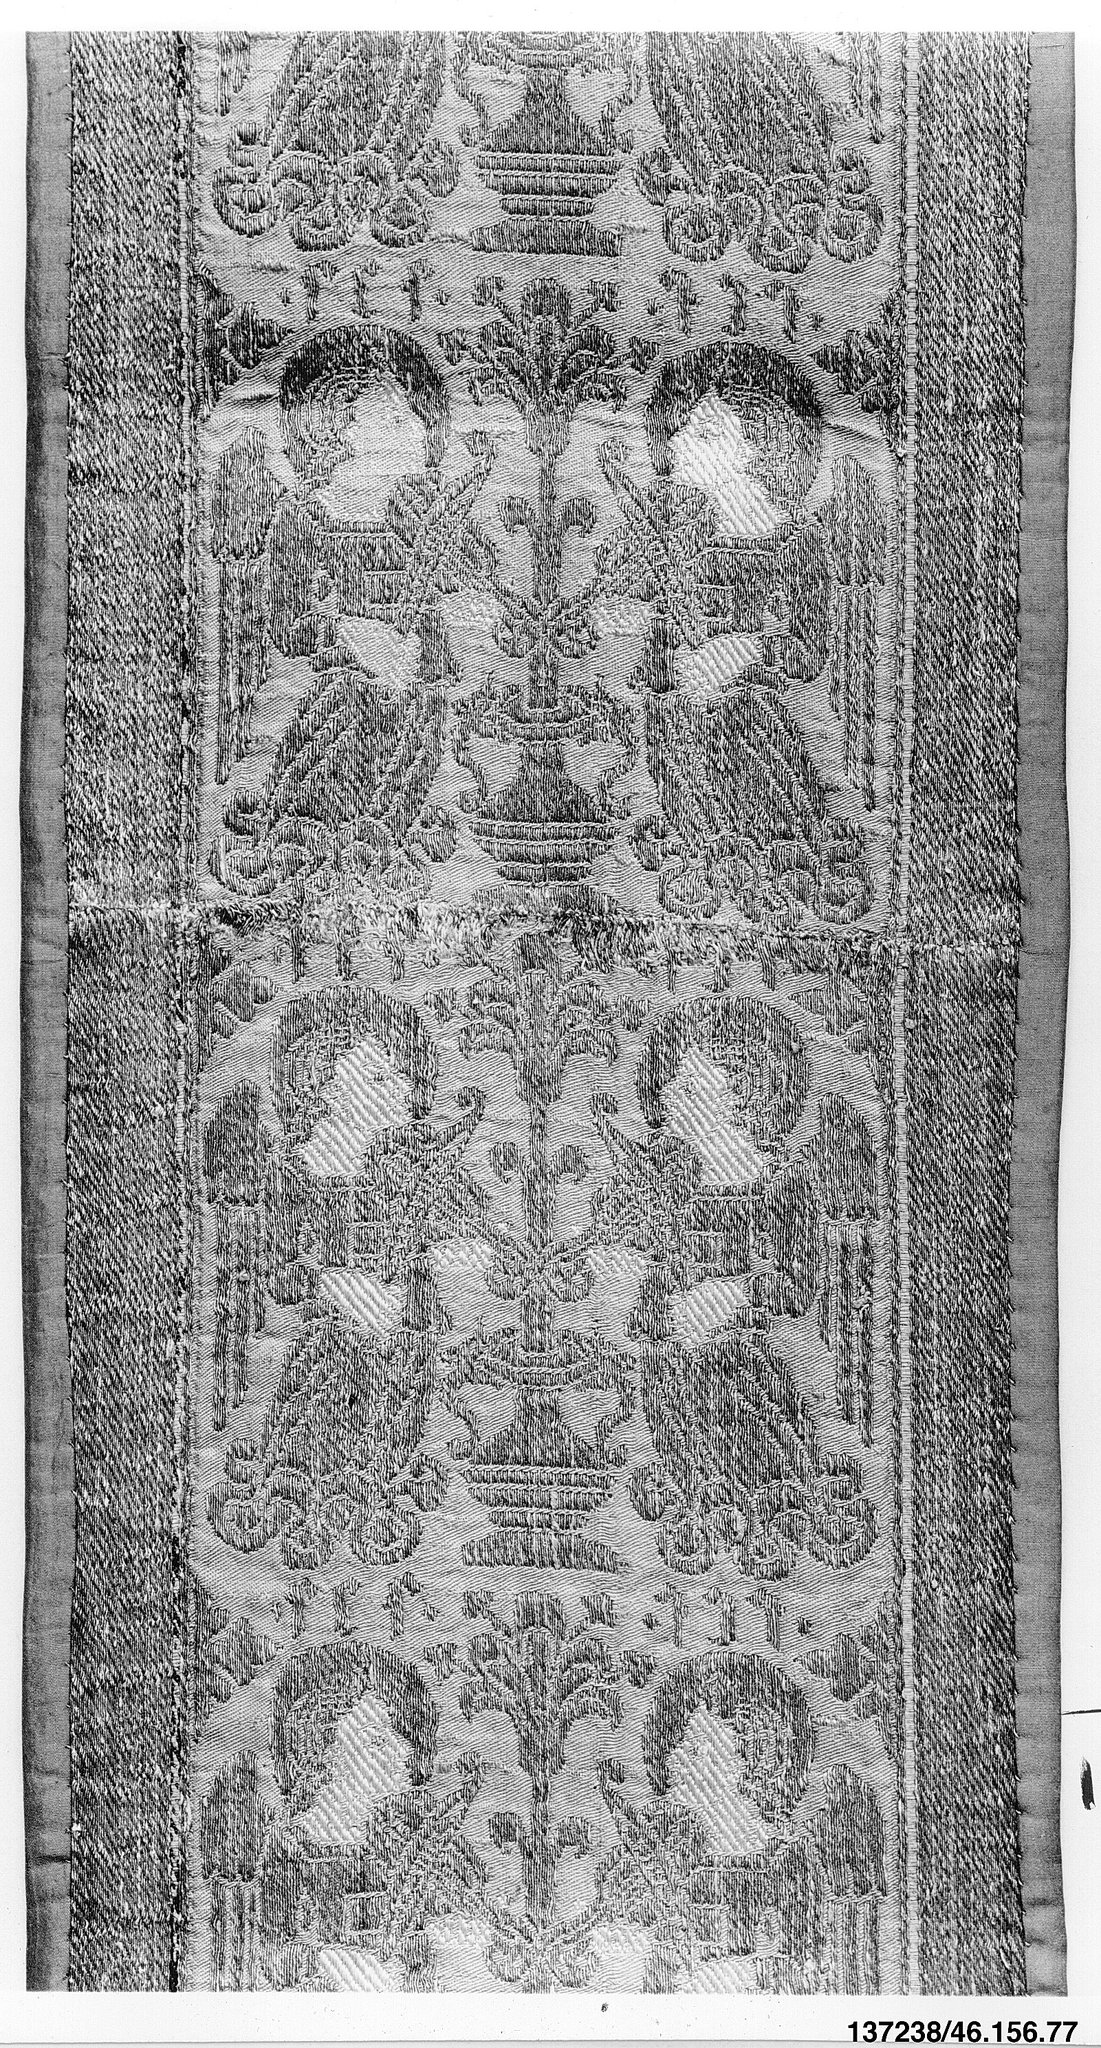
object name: orphrey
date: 1400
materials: linen, metal thread, silk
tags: angels